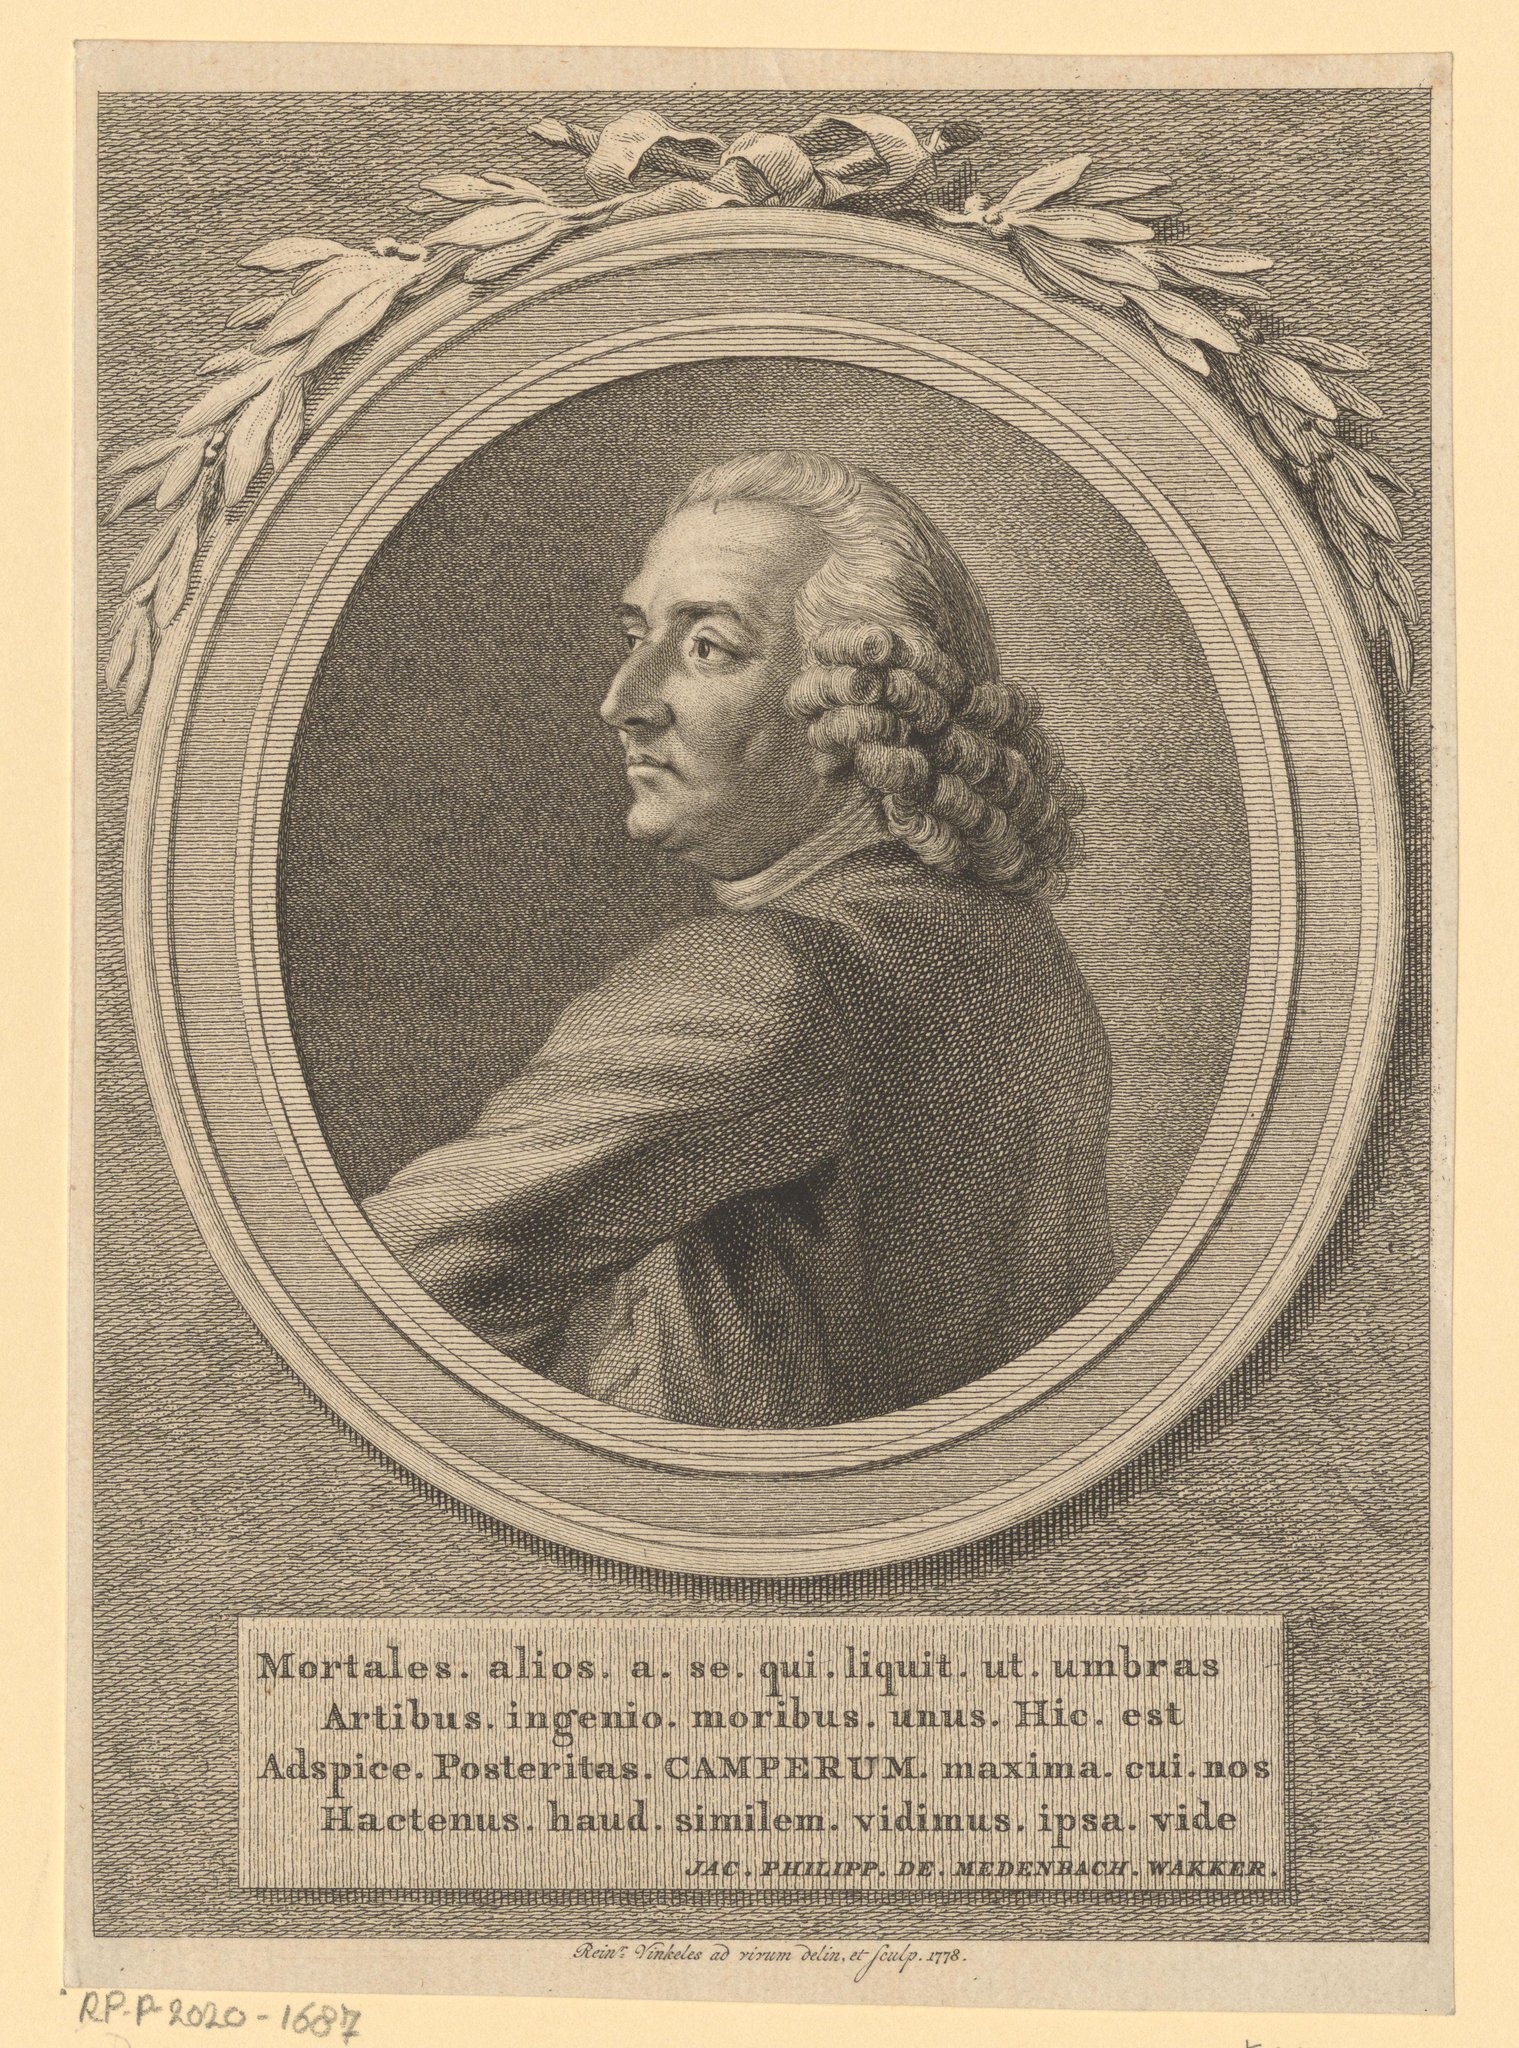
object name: print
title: Portret van Petrus Camper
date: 1778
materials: paper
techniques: engraving, etching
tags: print maker, draughtsman, petrus camper, historical persons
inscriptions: date